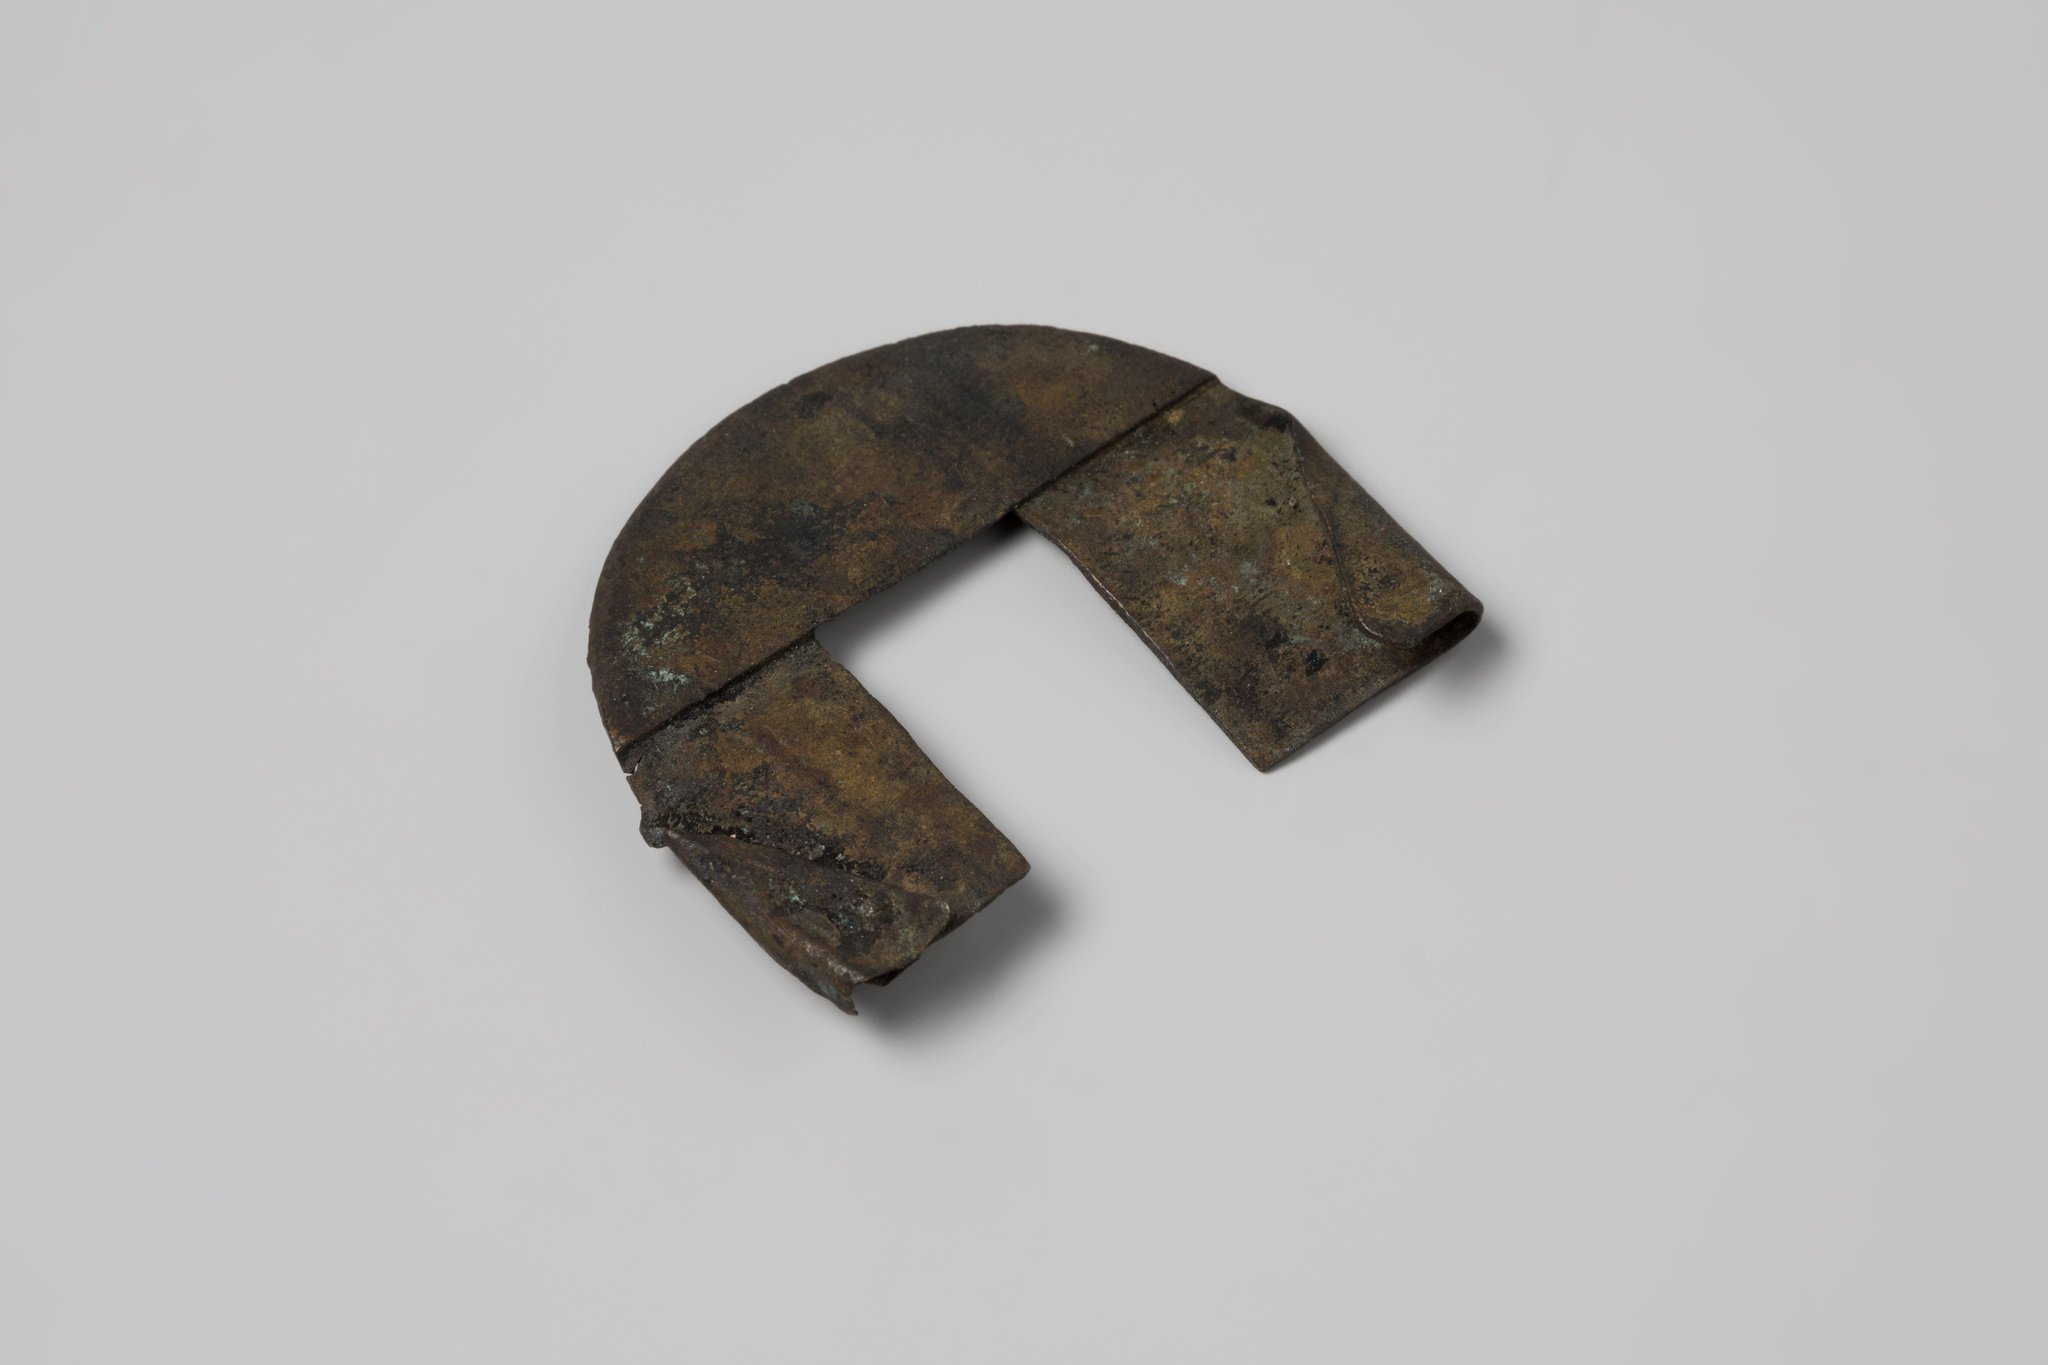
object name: graadstok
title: Vizier van de jacobsstaf uit het wrak van de Oost-Indiëvaarder Hollandia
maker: Anonymous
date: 1700-1743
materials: copper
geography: netherlands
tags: verenigde oostindische compagnie, hollandia (schip), annet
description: Navigation, cross staffs' vizor; id. NG 1980-27H102, squashed, lugs bent.